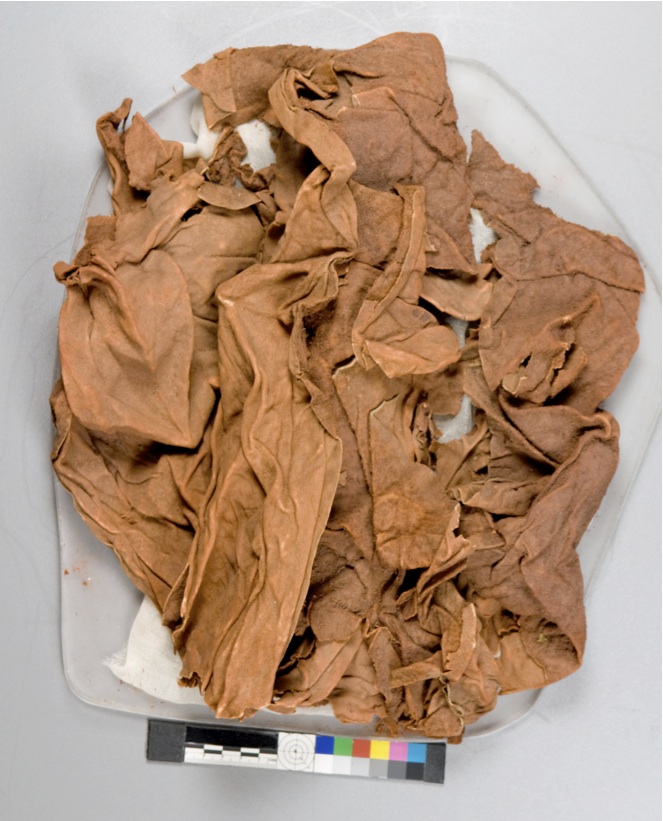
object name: leather bundle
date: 2050-2000 BCE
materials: leather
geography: egypt